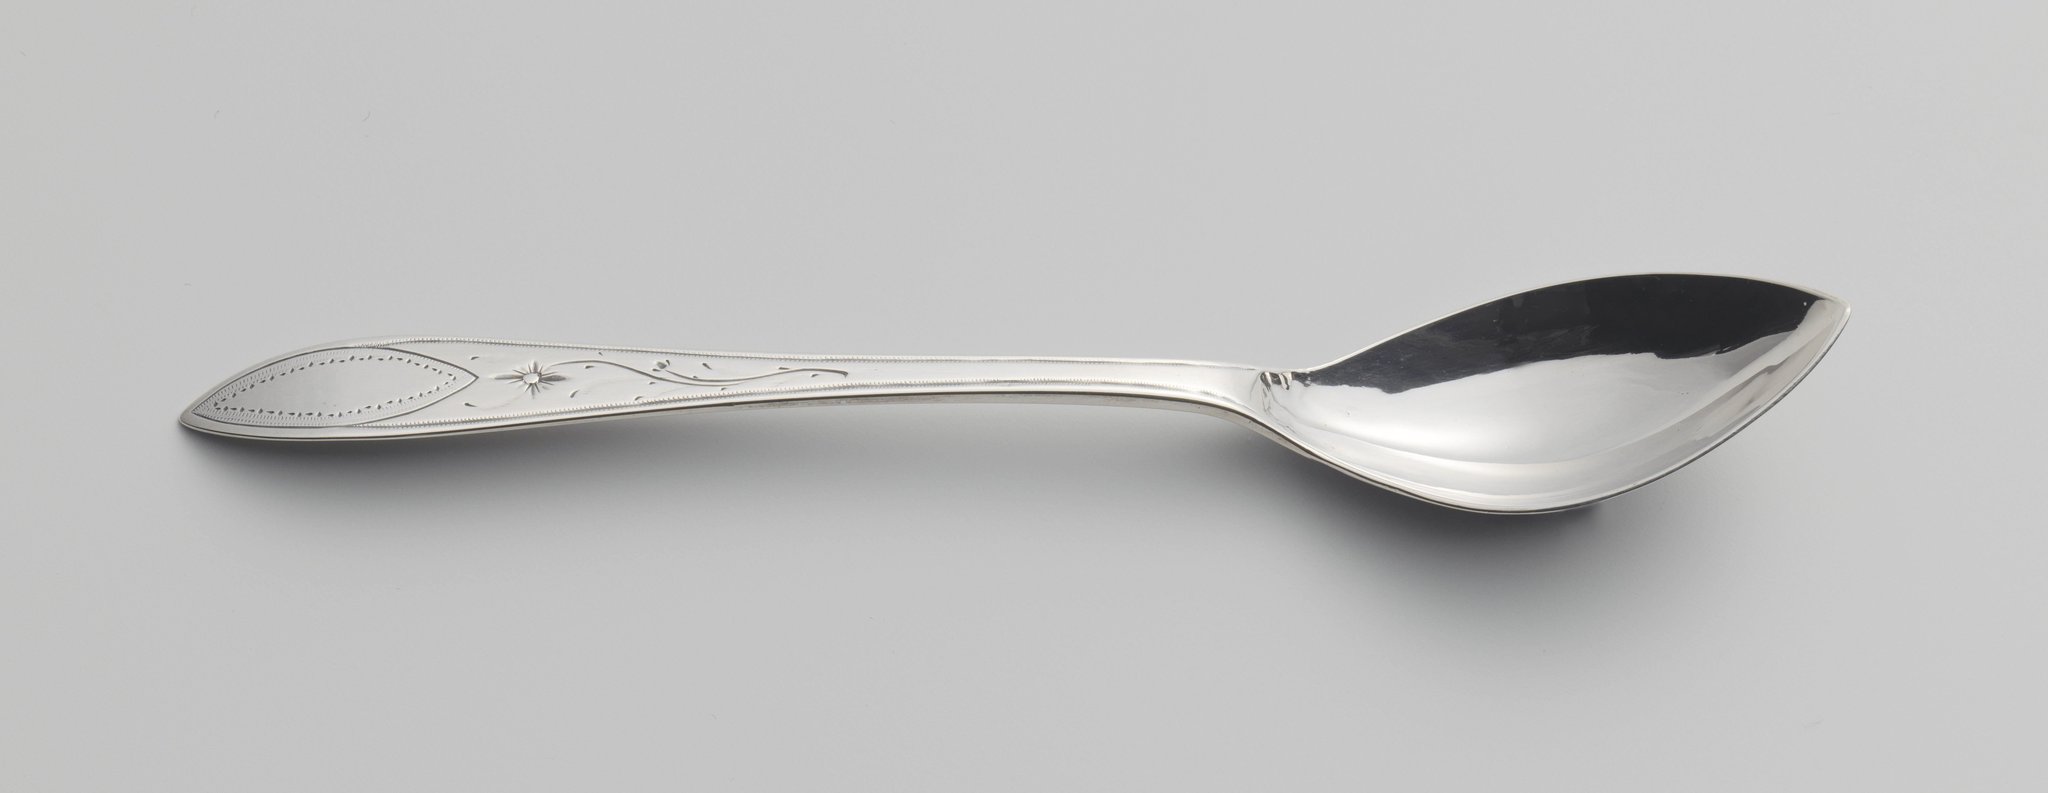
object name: teaspoon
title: Lepel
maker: cornelis knuysting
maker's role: silversmith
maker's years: 1730-1812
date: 1802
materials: silver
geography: rotterdam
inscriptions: mark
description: Lepel van zilver, met spits ovale bak en spits toelopende steel. De steel is aan de bovenzijde gegraveerd met een bloemrank en een ovaal medaillon.